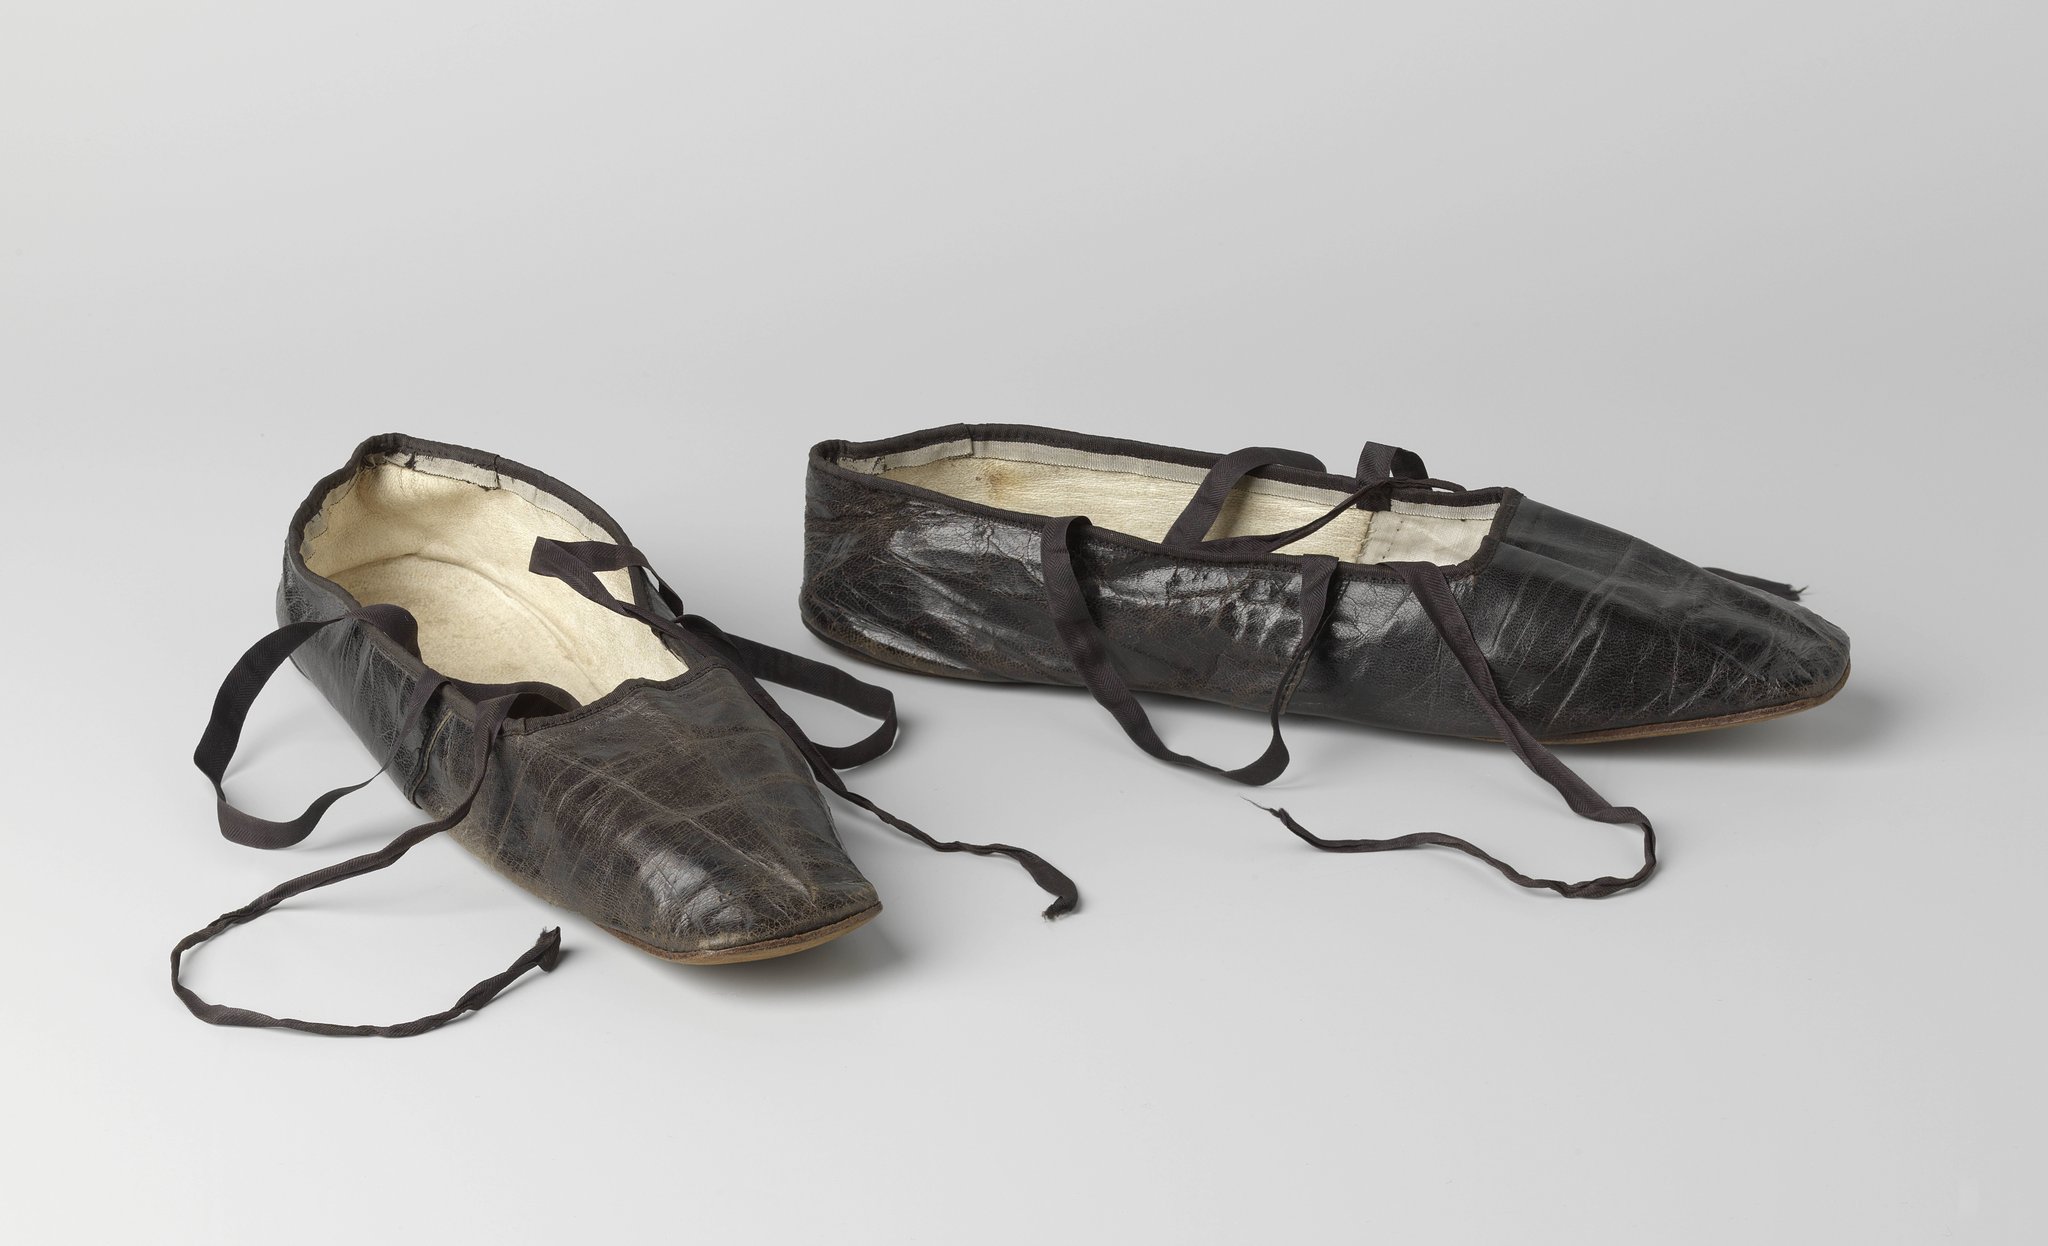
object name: clothing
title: Schoen van zwart leer met linten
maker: Anonymous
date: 1830-1850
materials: cotton, leather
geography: northern netherlands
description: Een paar schoenen van zwart leer. Geen links of rechts. Geen hak, spits toelopende zool. Vierkante neus. Zwarte lintjes kunnen kruiselings gesloten worden over wreef en enkel.